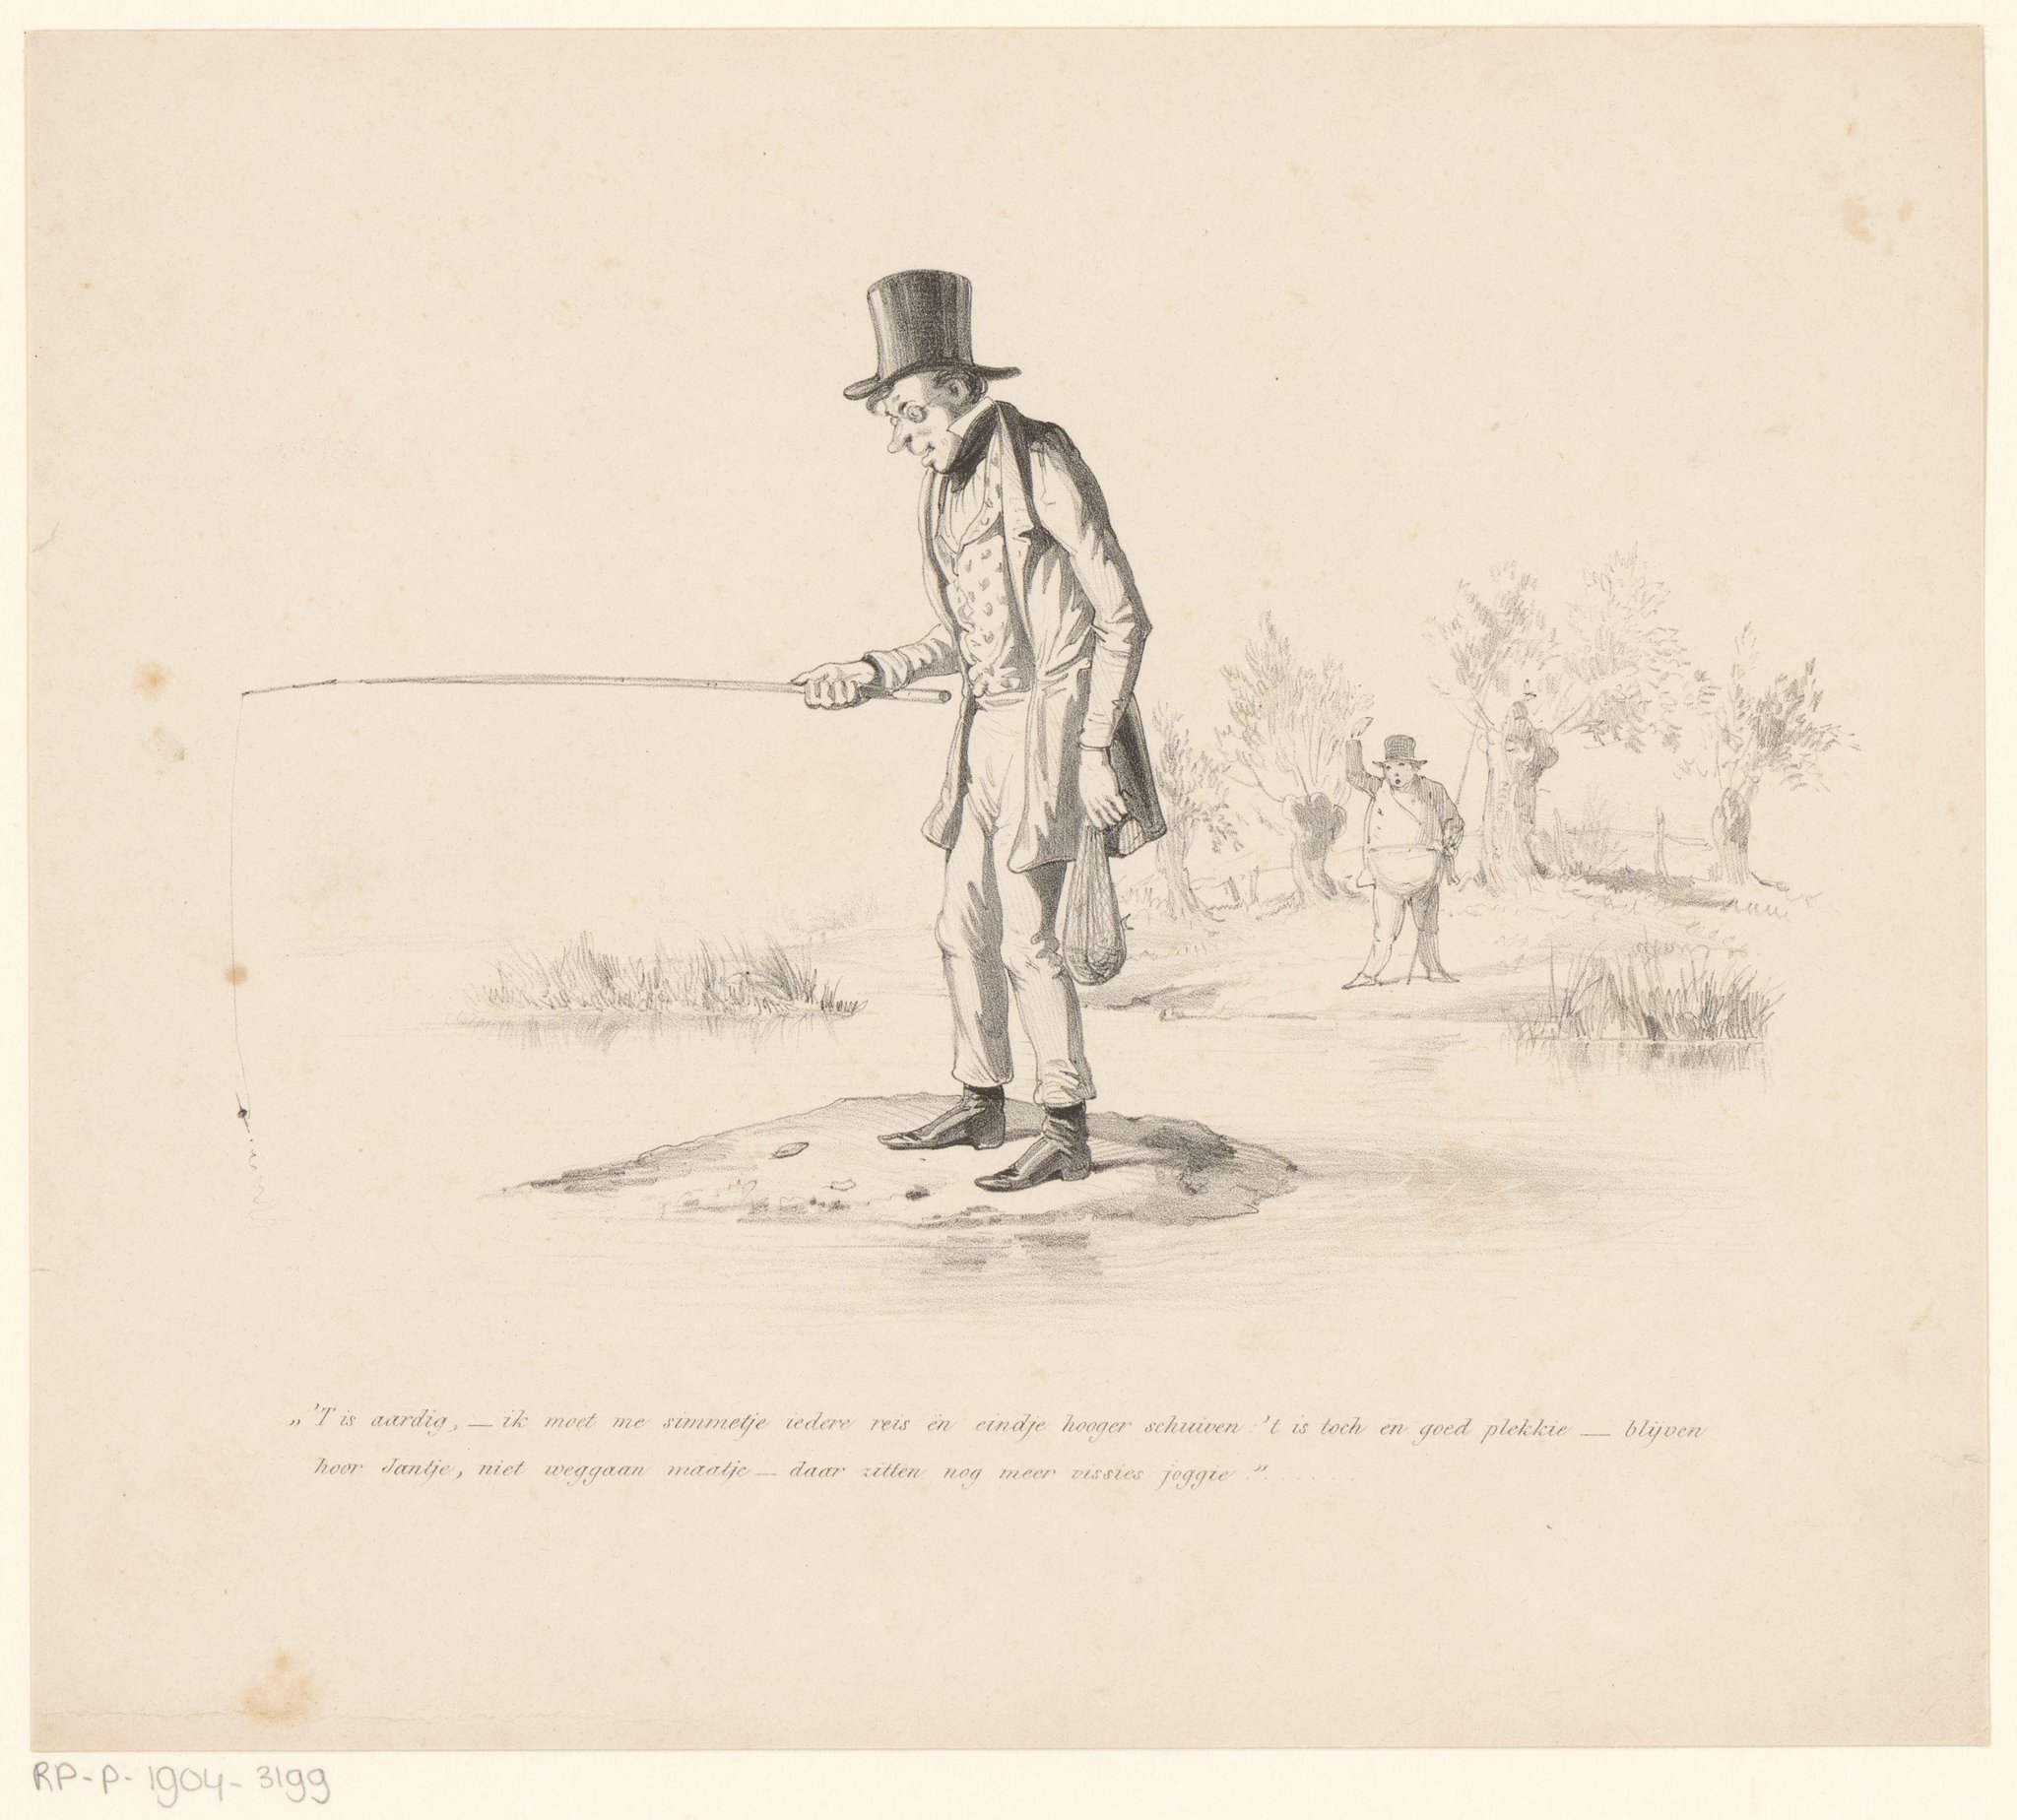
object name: print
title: Visser op eiland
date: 1832-1897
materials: paper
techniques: lithograph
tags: fishing (sports)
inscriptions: collector's mark: Lugt 2228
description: Een vissende man met hoge hoed staat op een eiland. Op de oever zwaait een man met hengel naar hem.